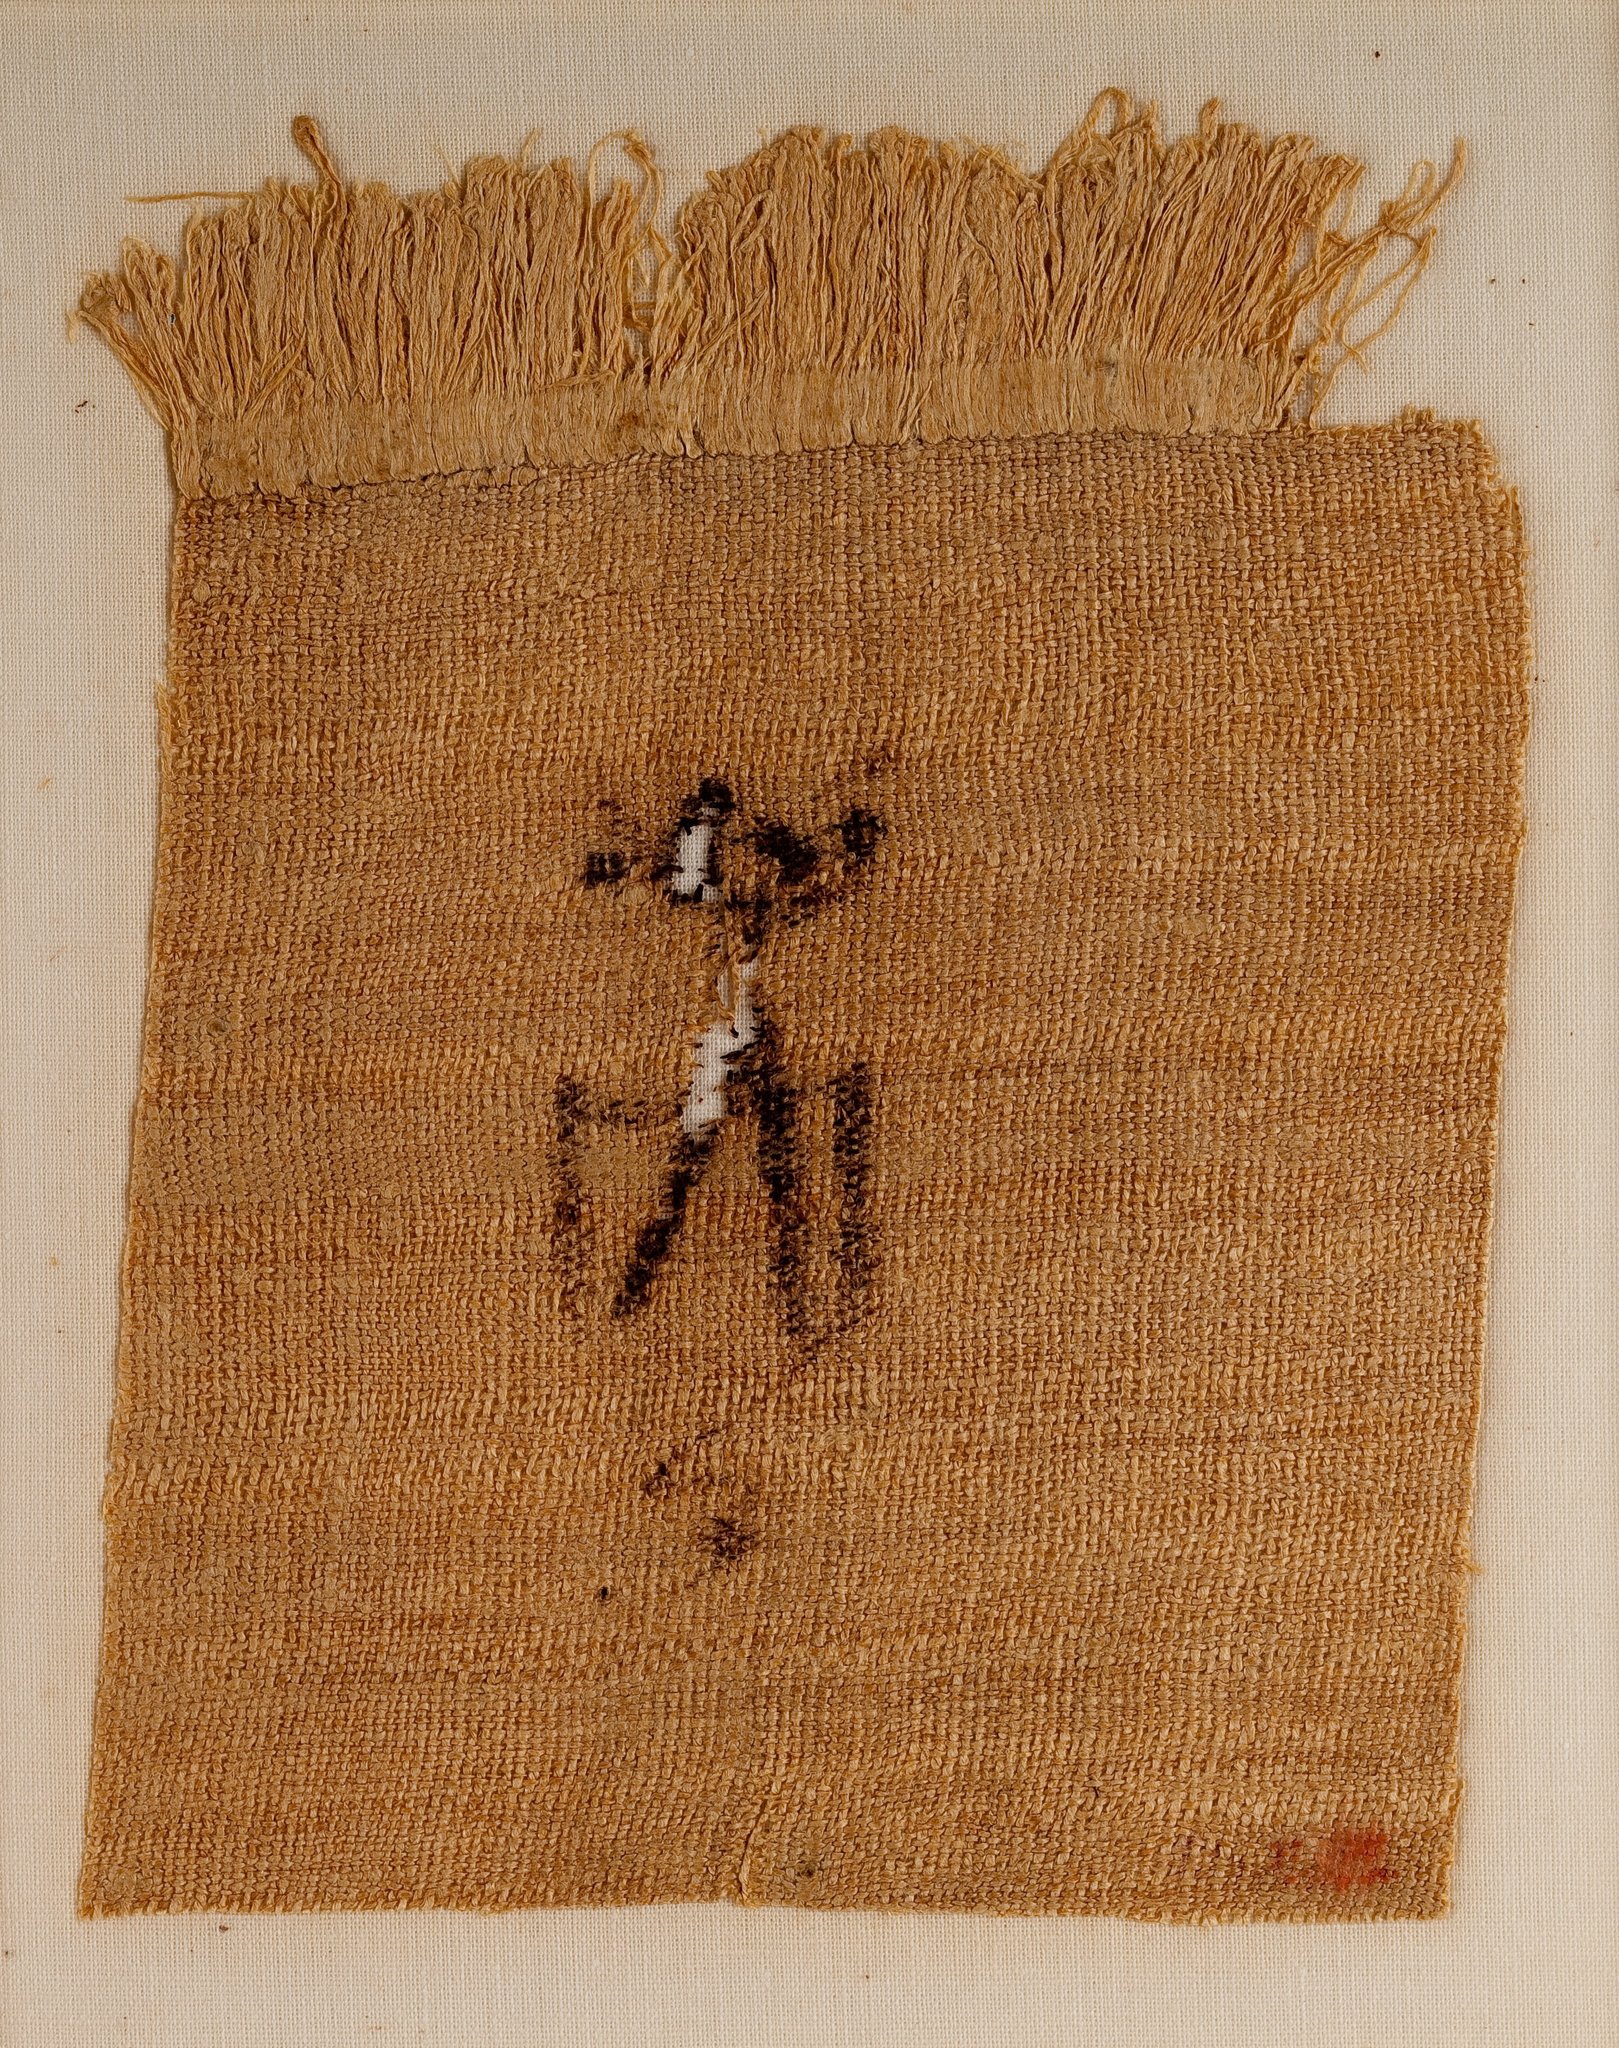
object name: linen mark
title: Linen mark (Type V)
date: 1961-1917 BCE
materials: linen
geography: egypt